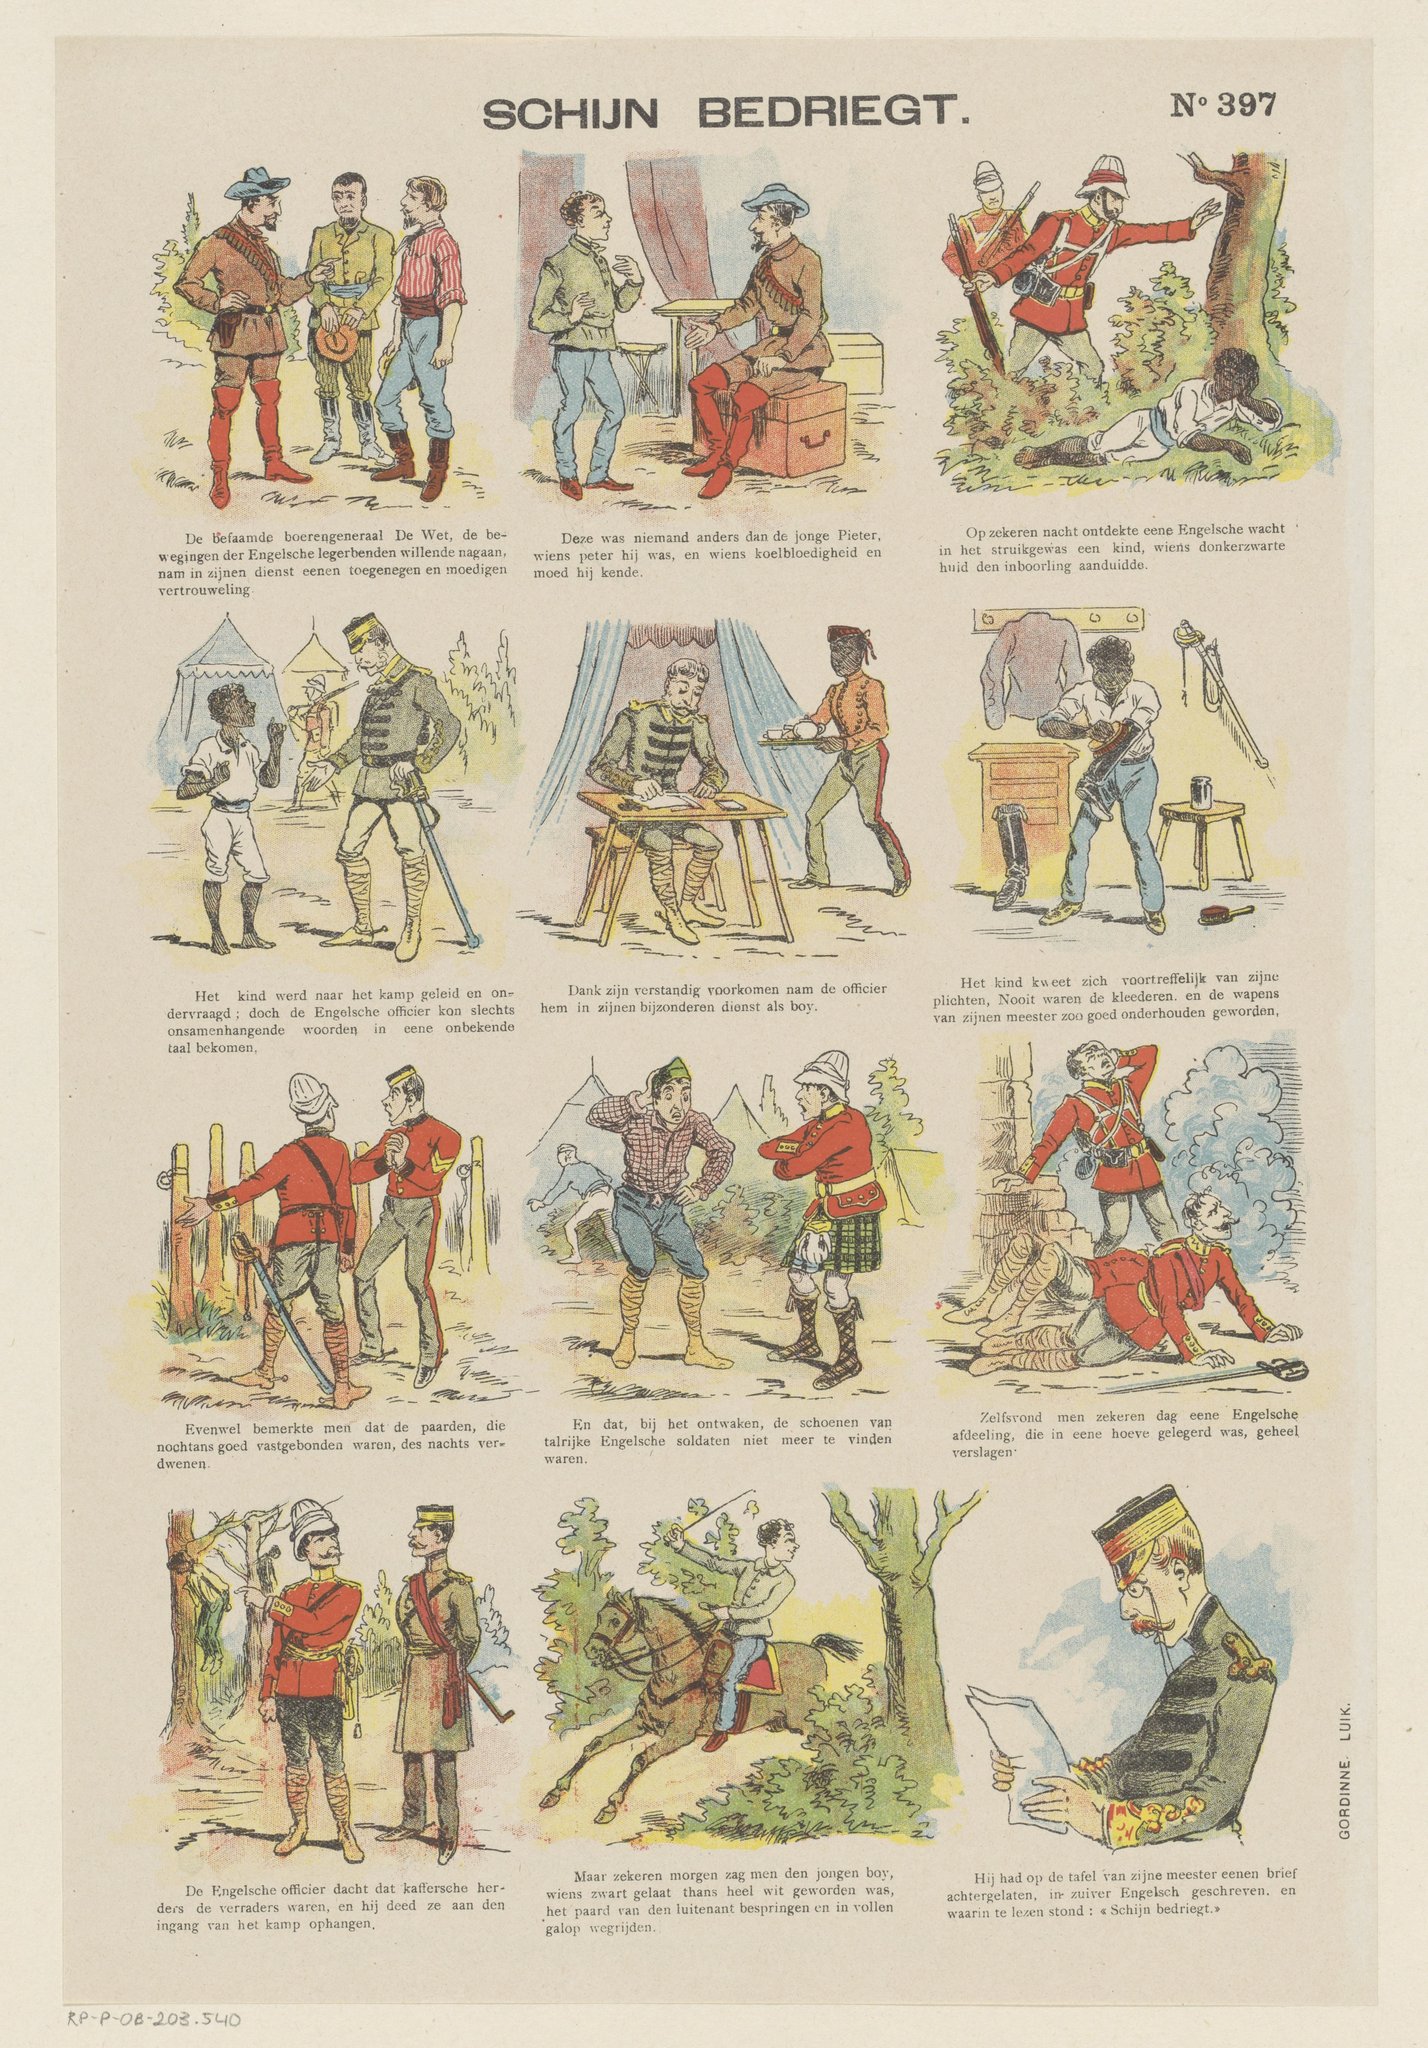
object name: print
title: Schijn bedriegt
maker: Anonymous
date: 1894-1959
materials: paper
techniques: lithograph, letterpress printing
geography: liège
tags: africans, the soldier; the soldier's life, disguise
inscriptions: collector's mark: Lugt 2760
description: Blad met 12 voorstellingen over de jonge Pieter die zich voordoet als zwarte jongen en zo infiltreert in het kamp van de Engelsen, tijdens de Tweede Boerenoorlog 1899-1902. Onder elke afbeelding een onderschrift. Genummerd rechtsboven: No 397.